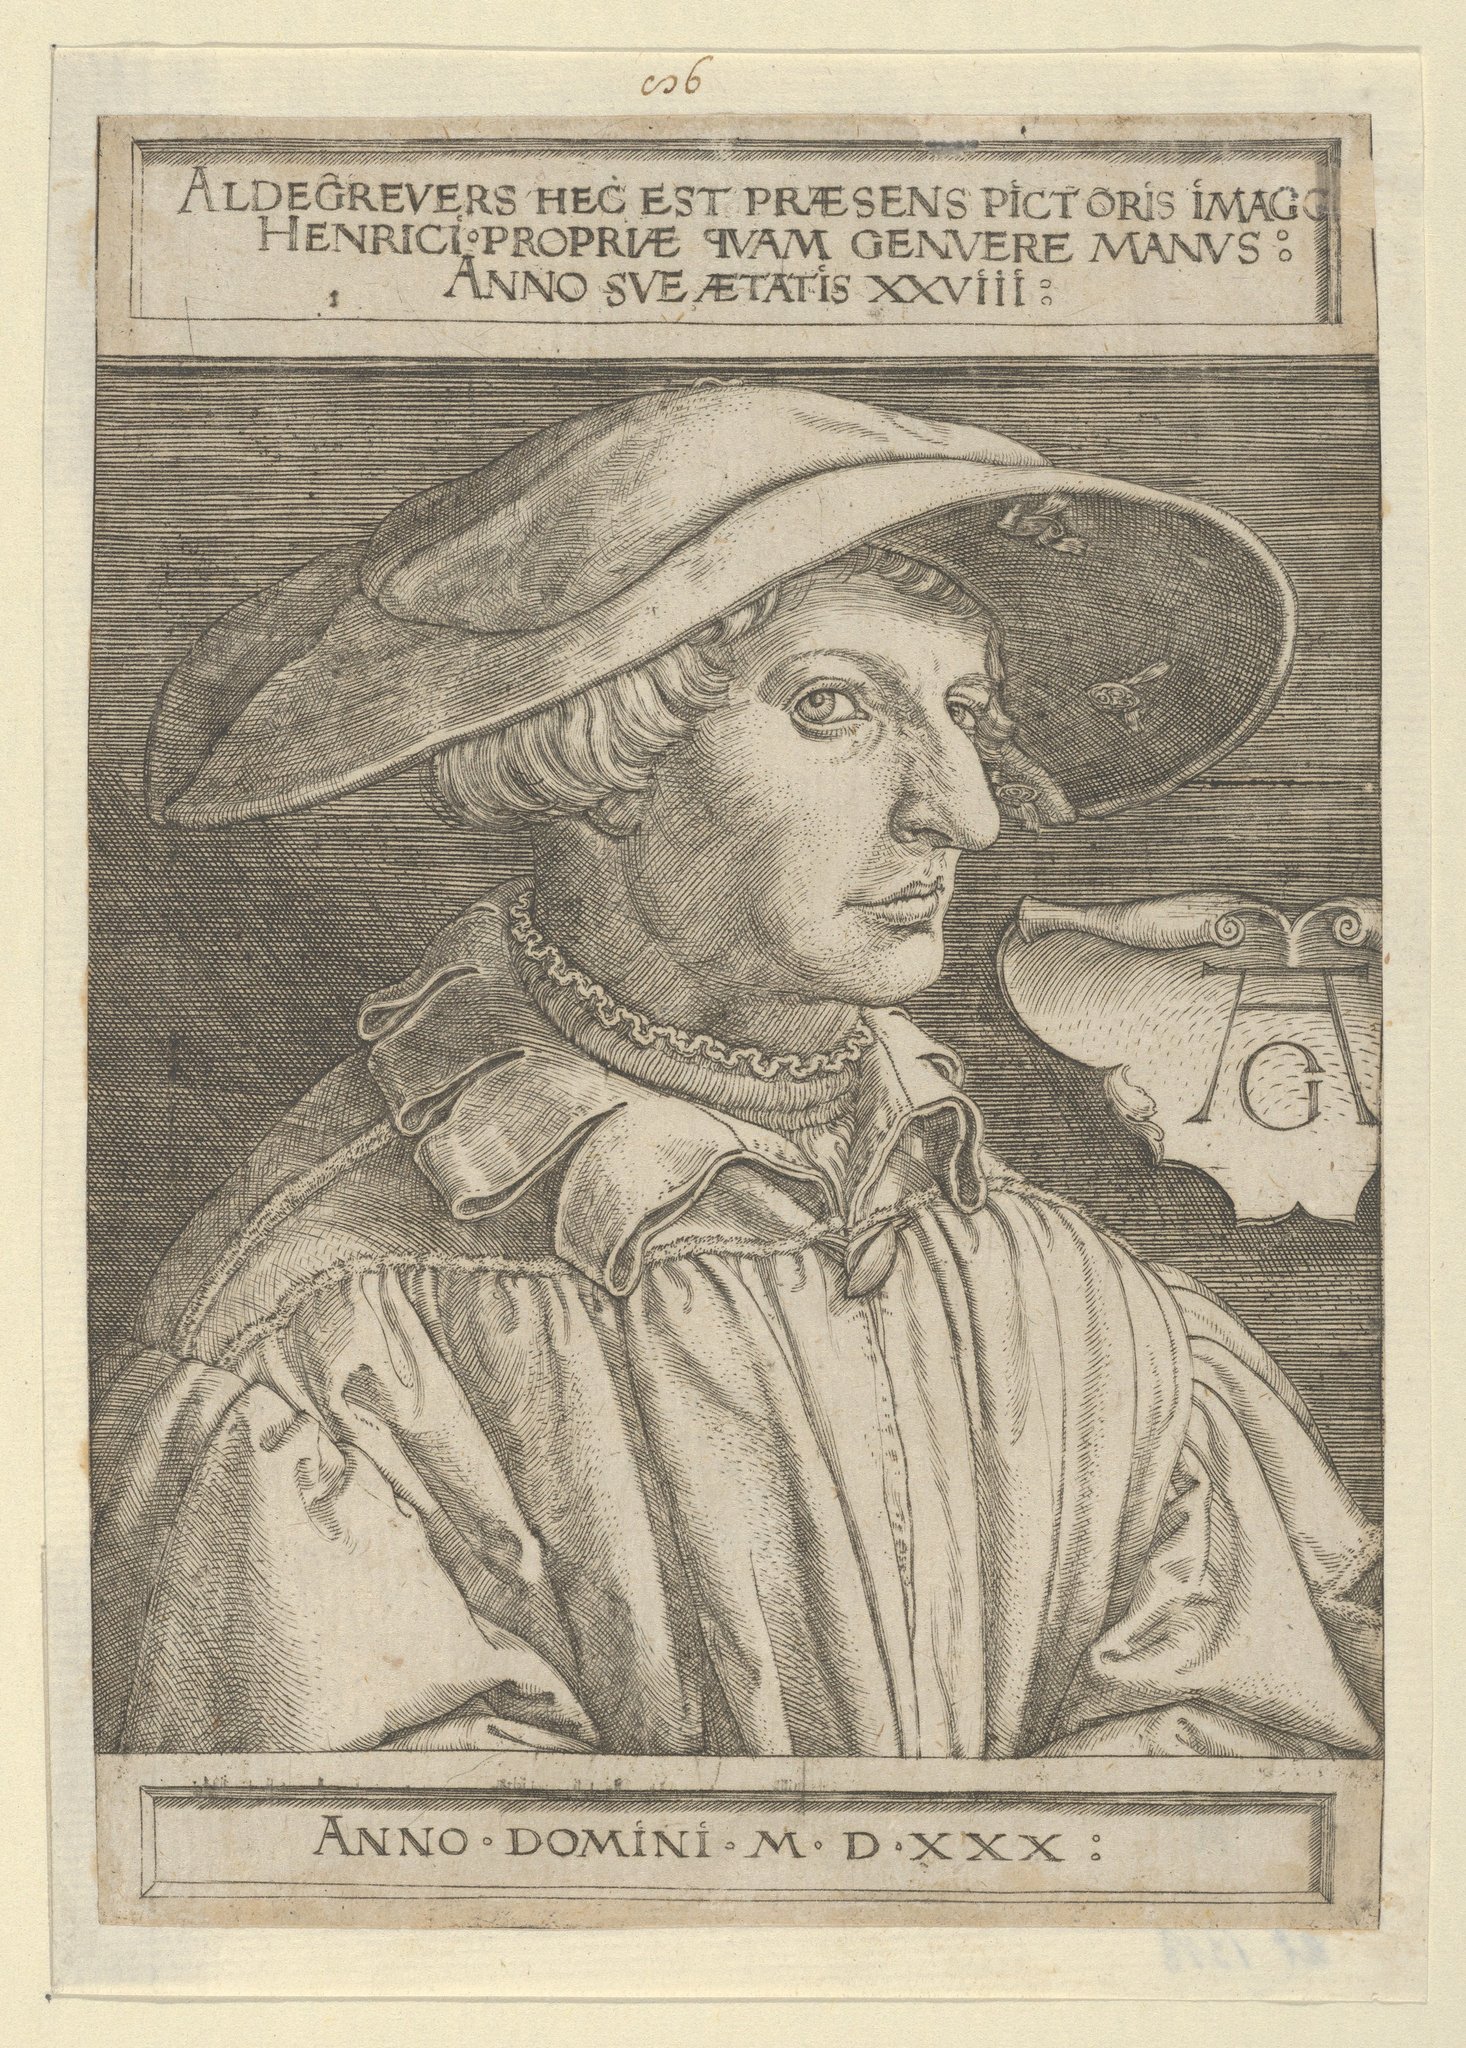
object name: print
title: Self-Portrait at Age Twenty-Eight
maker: heinrich aldegrever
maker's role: artist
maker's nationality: german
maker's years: 1502-1561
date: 1530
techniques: engraving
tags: portraits,women